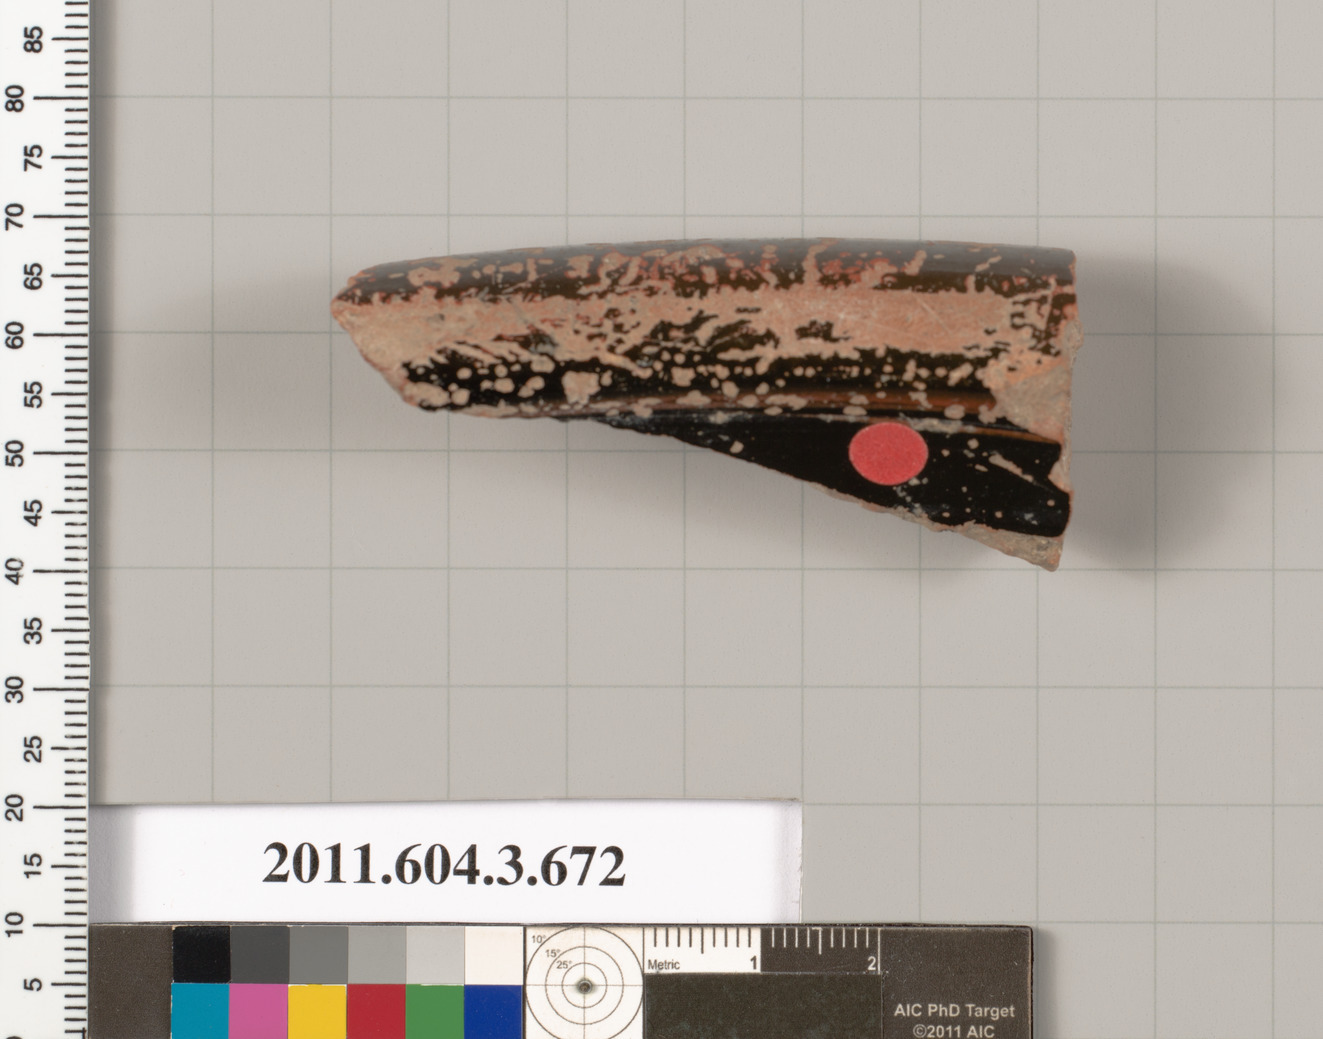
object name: calyx krater fragment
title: Terracotta fragment of a calyx-krater (bowl for mixing wine and water)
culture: greek, attic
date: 525-501 BCE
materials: terracotta